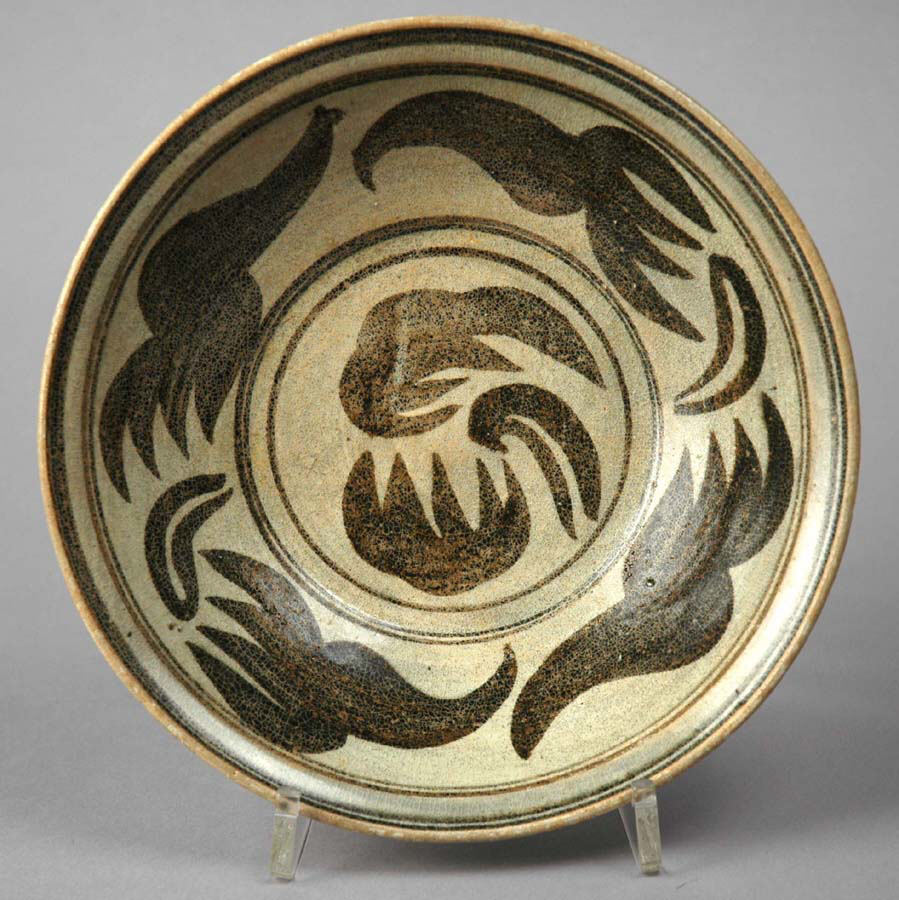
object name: dish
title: Dish with Floral Design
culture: thai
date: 1367-1533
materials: iron, stoneware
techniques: underglaze